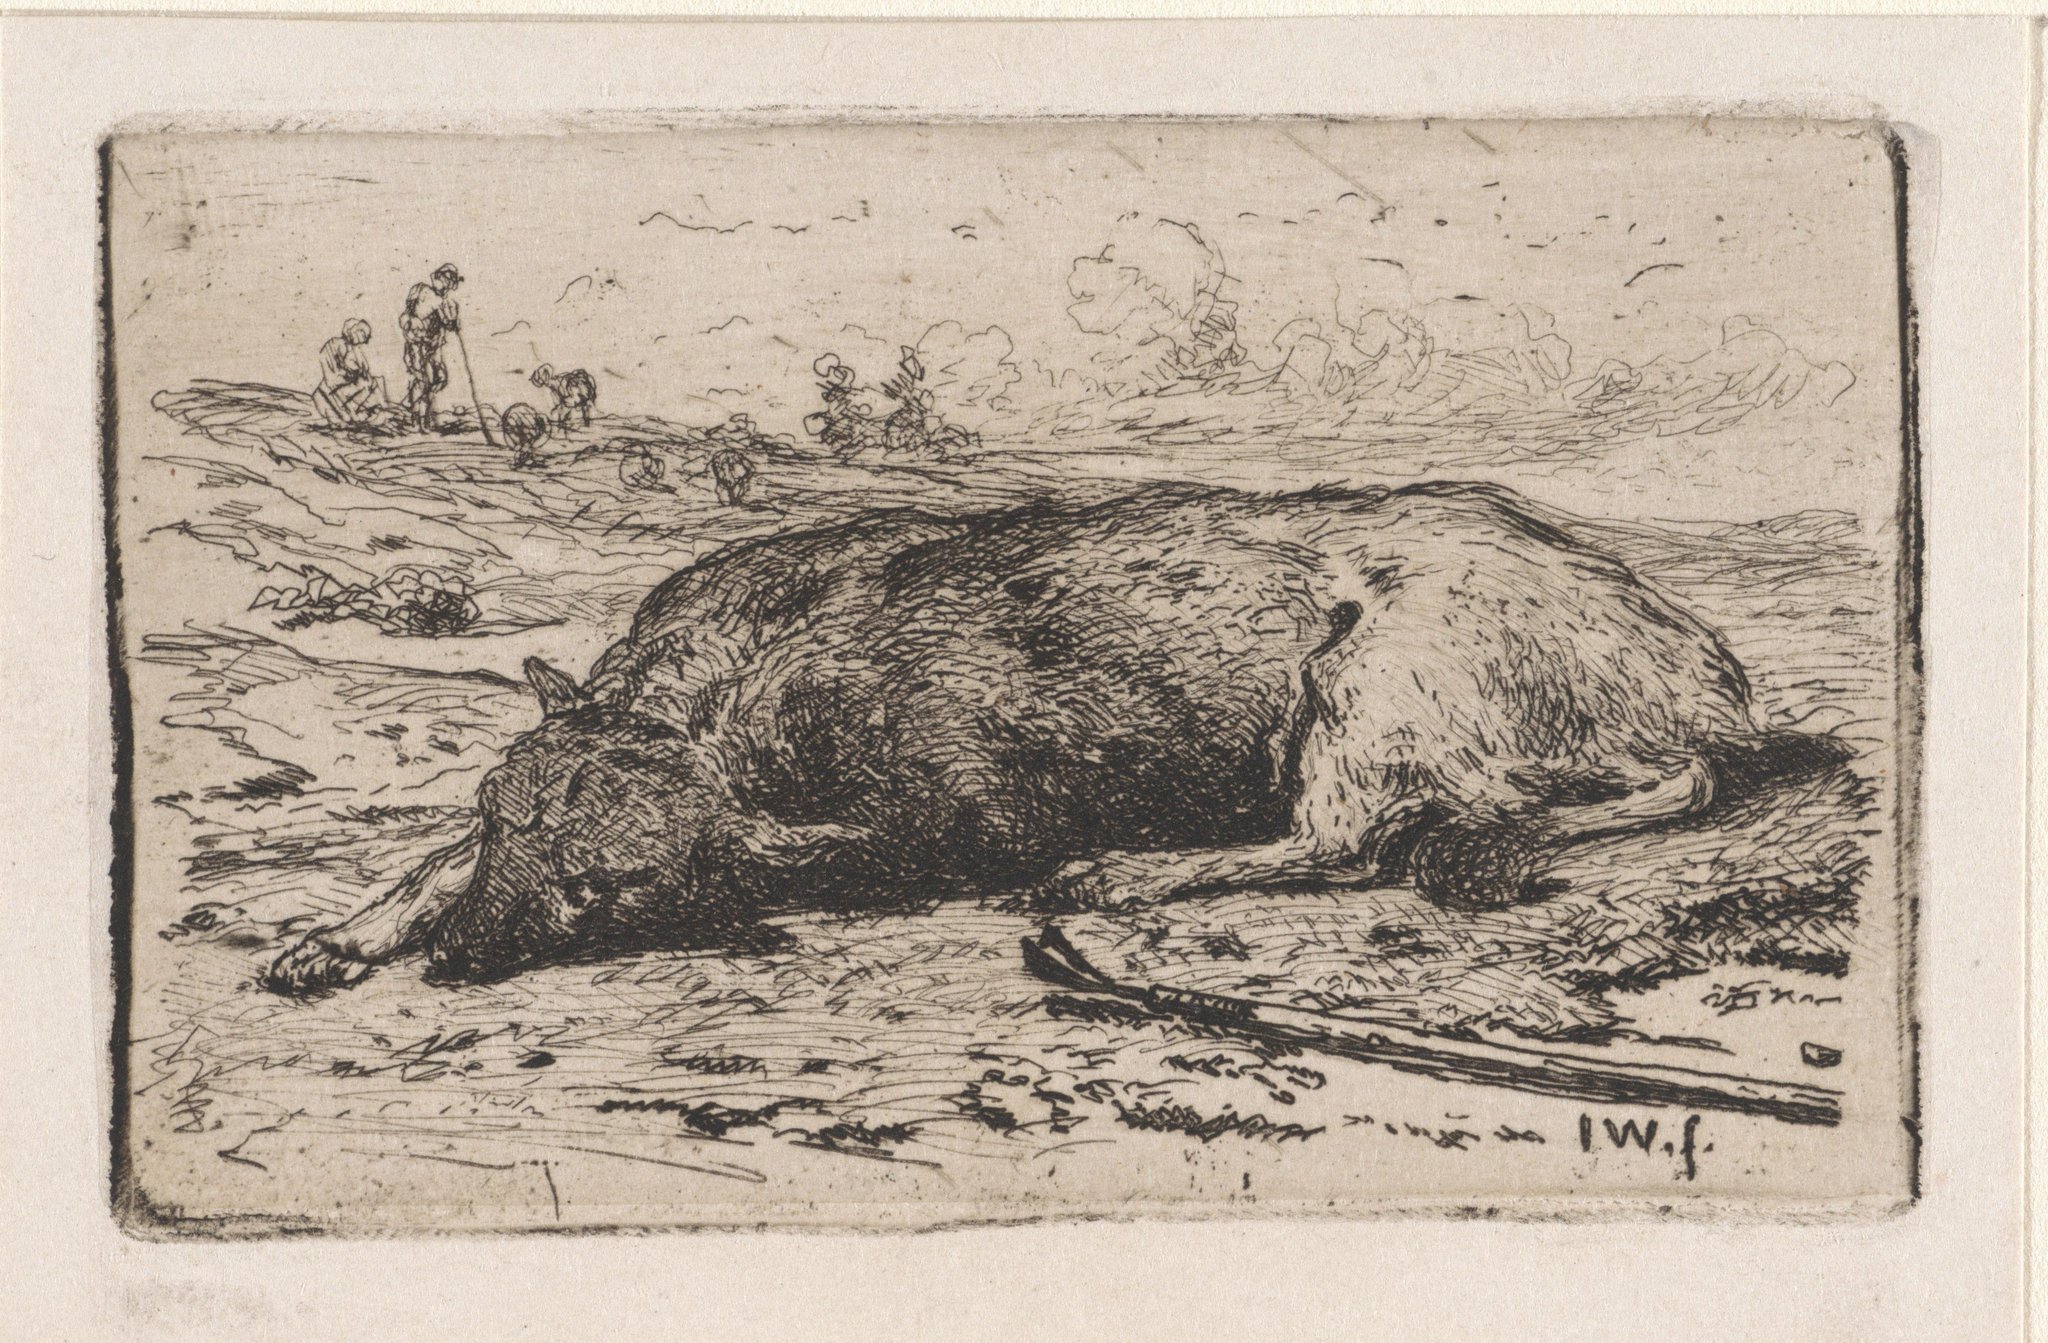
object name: print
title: Slapende hond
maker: jan weissenbruch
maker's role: painter, print maker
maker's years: 1822-1880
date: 1837-1880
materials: paper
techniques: etching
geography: the hague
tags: landscapes, herding, herdsman, herdswoman, shepherd, shepherdess, cowherd, etc., walking-stick, staff, sleeping on the ground, goat, herd, flock, dog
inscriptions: collector's mark: Lugt 2228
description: Een hond ligt op de grond bij een stok te slapen. Zijn rechtervoorpoot heeft hij uitgestrekt. In de verte loopt een kudde dieren, mogelijk geiten, in de buurt van een herder en een herderin.